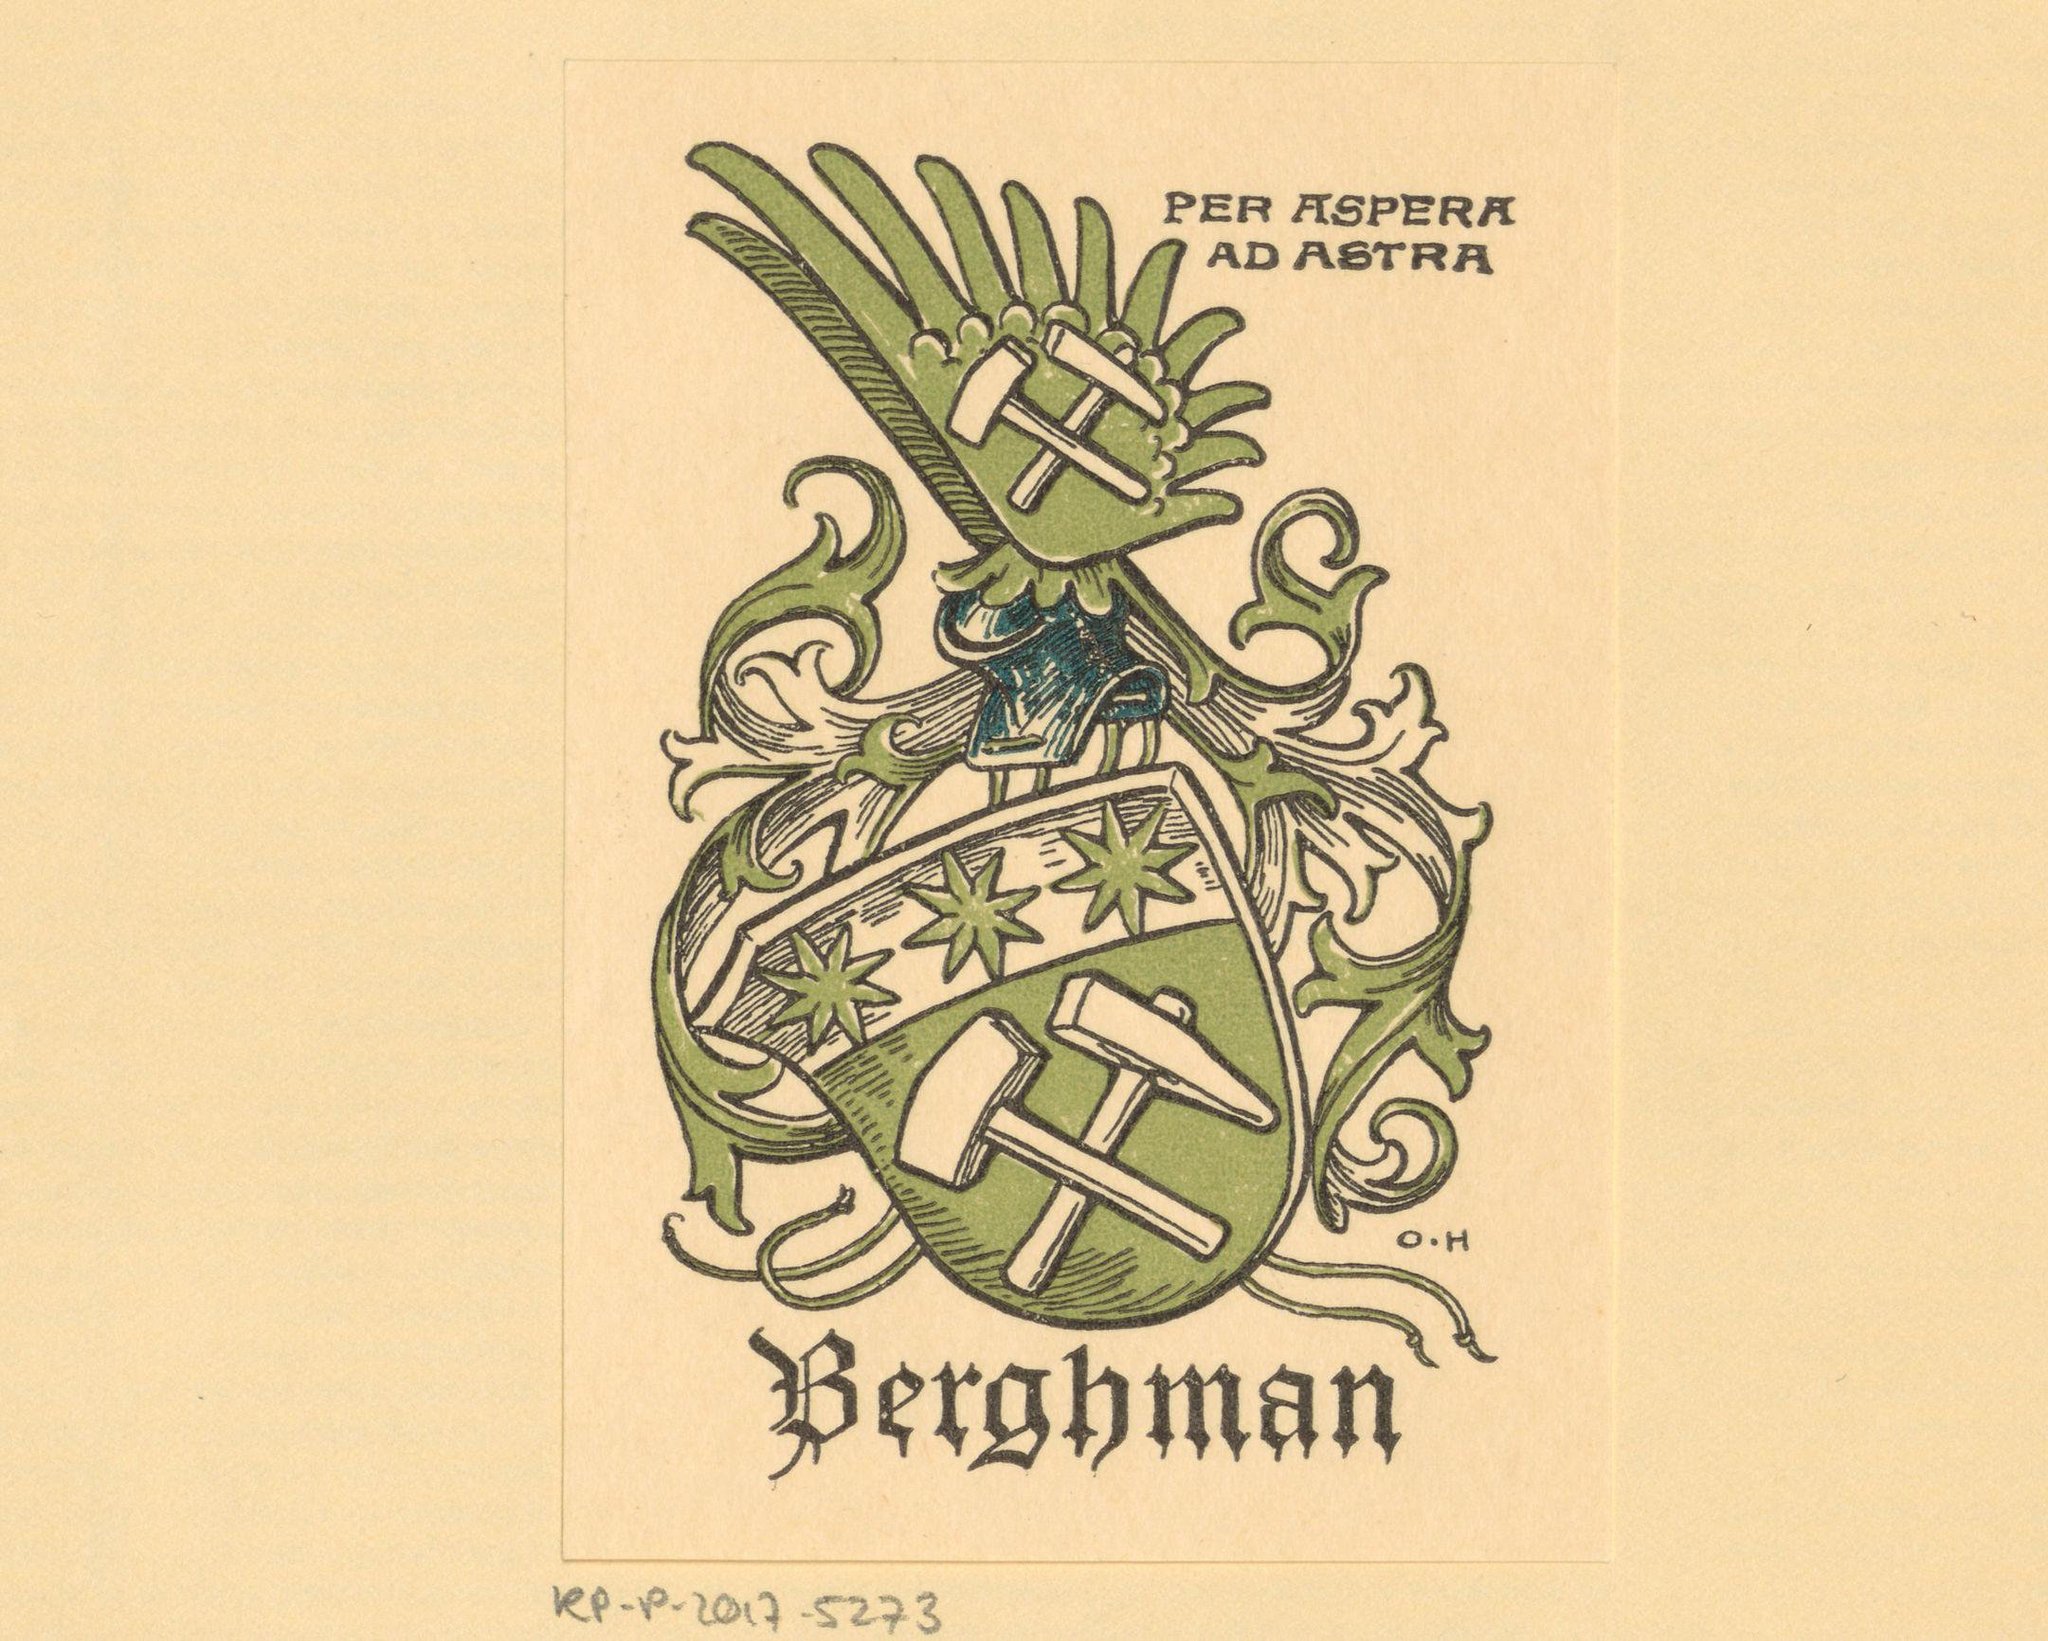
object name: bookplate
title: Ex libris van Berghman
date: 1869-1949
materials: paper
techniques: printing block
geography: austria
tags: tools, aids, implements ~ crafts and industries: hammer, armorial bearing, heraldry